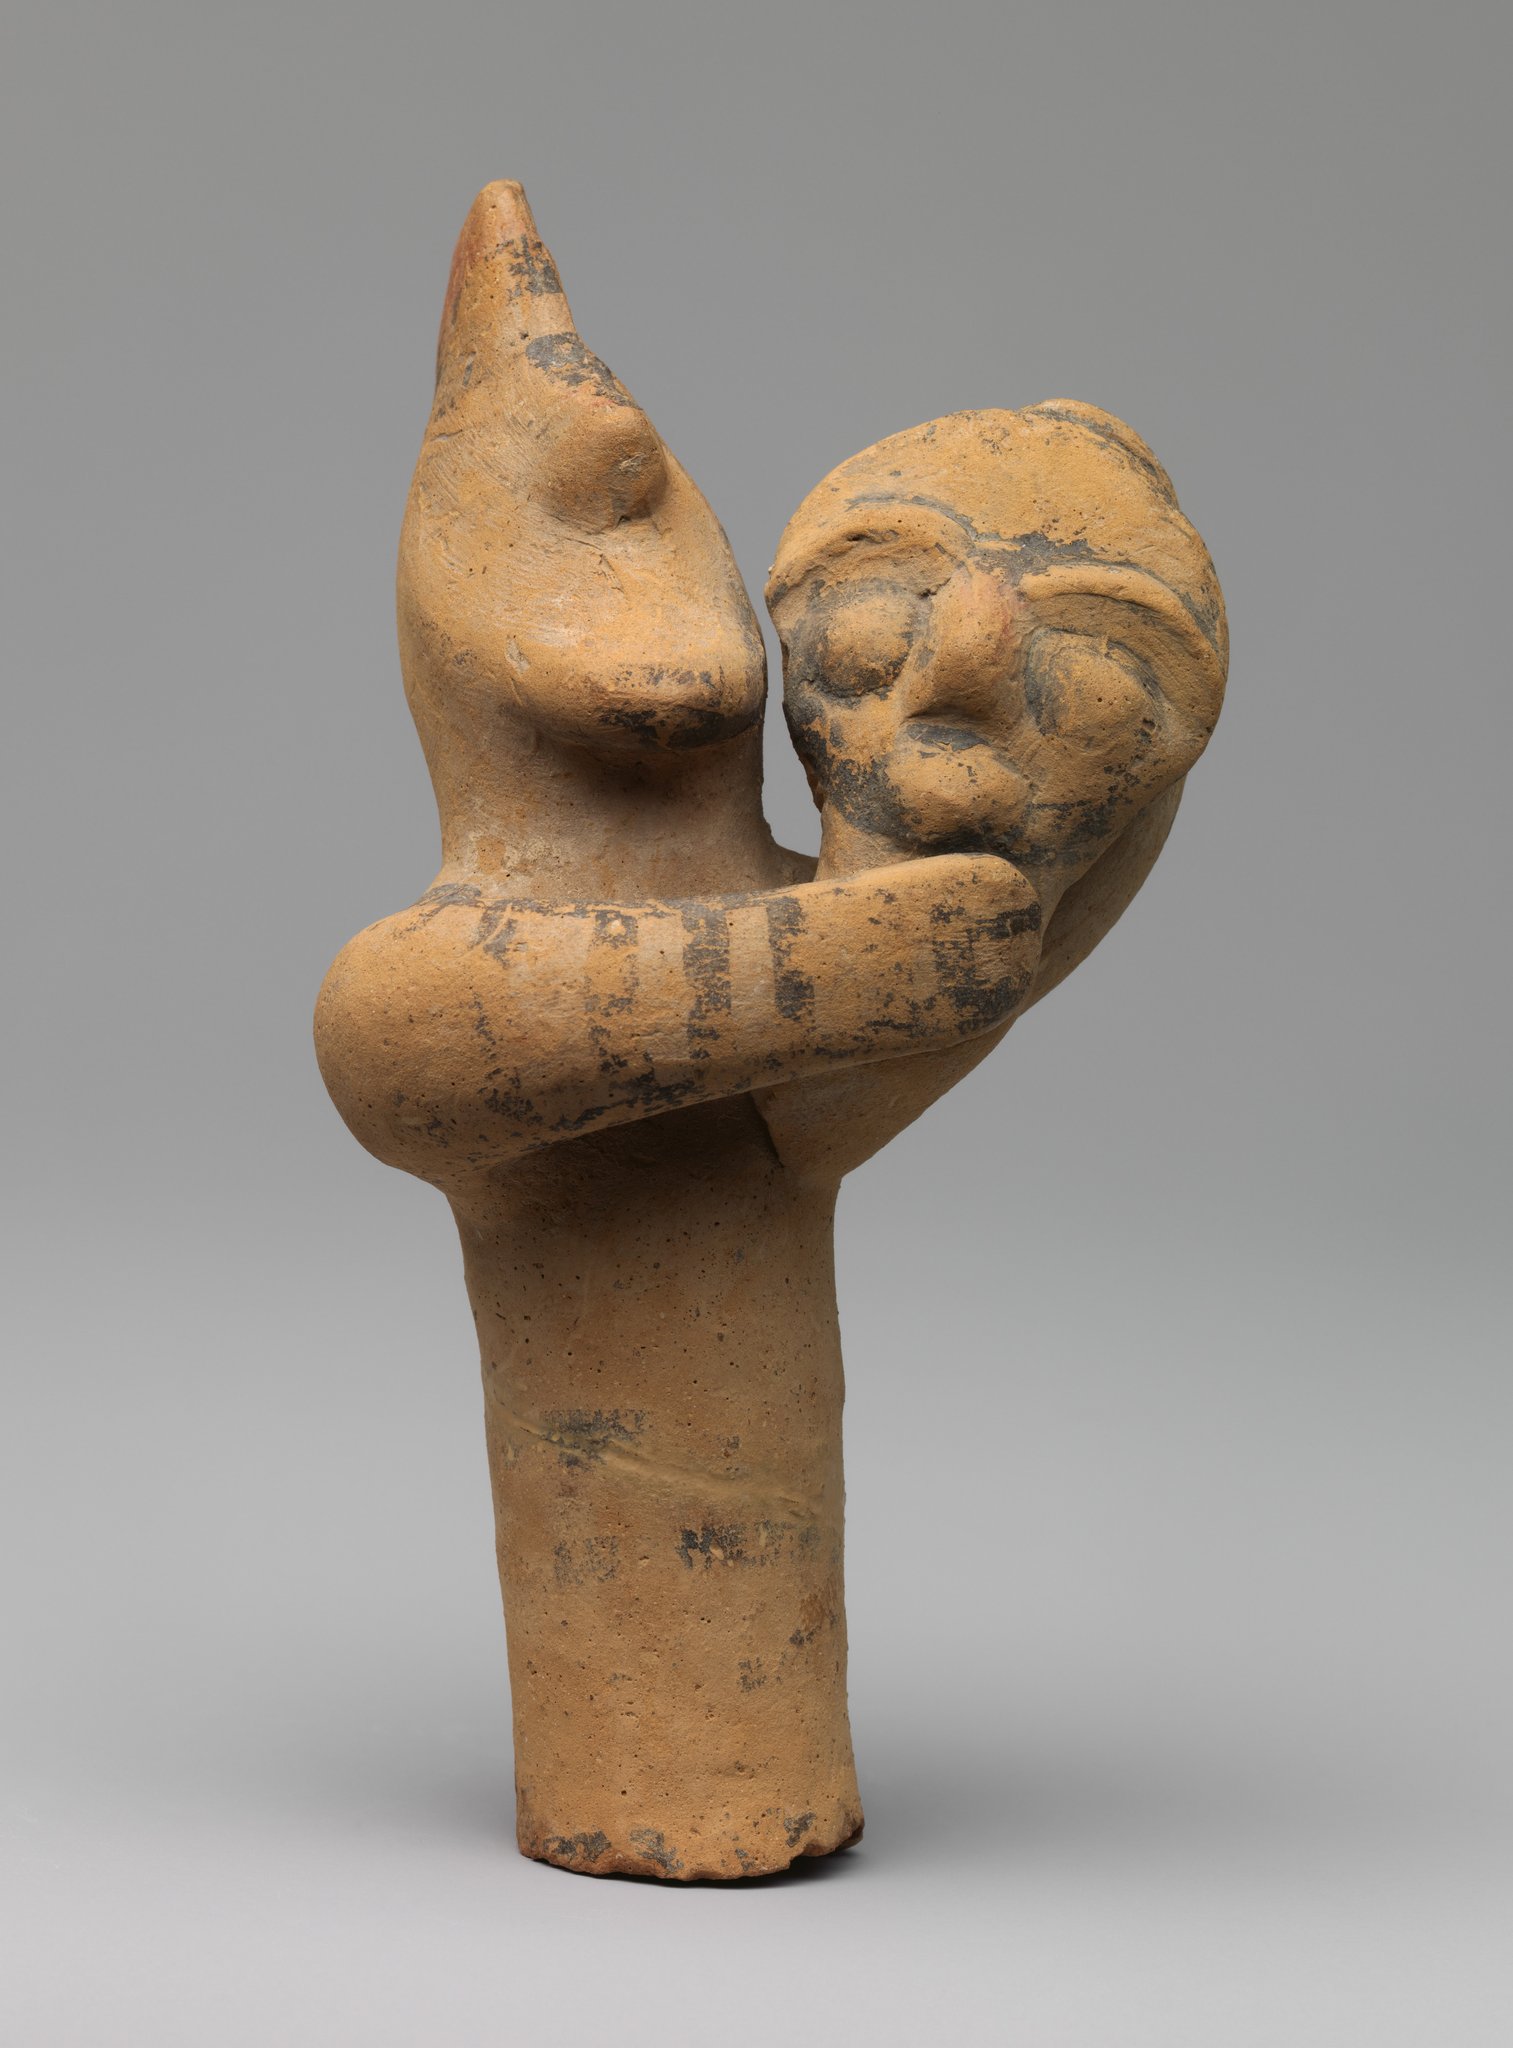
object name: figurine of a man holding a protome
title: Terracotta statuette of a male figure holding the head and neck of a mask or image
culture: cypriot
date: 750-600 BCE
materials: terracotta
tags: masks,men